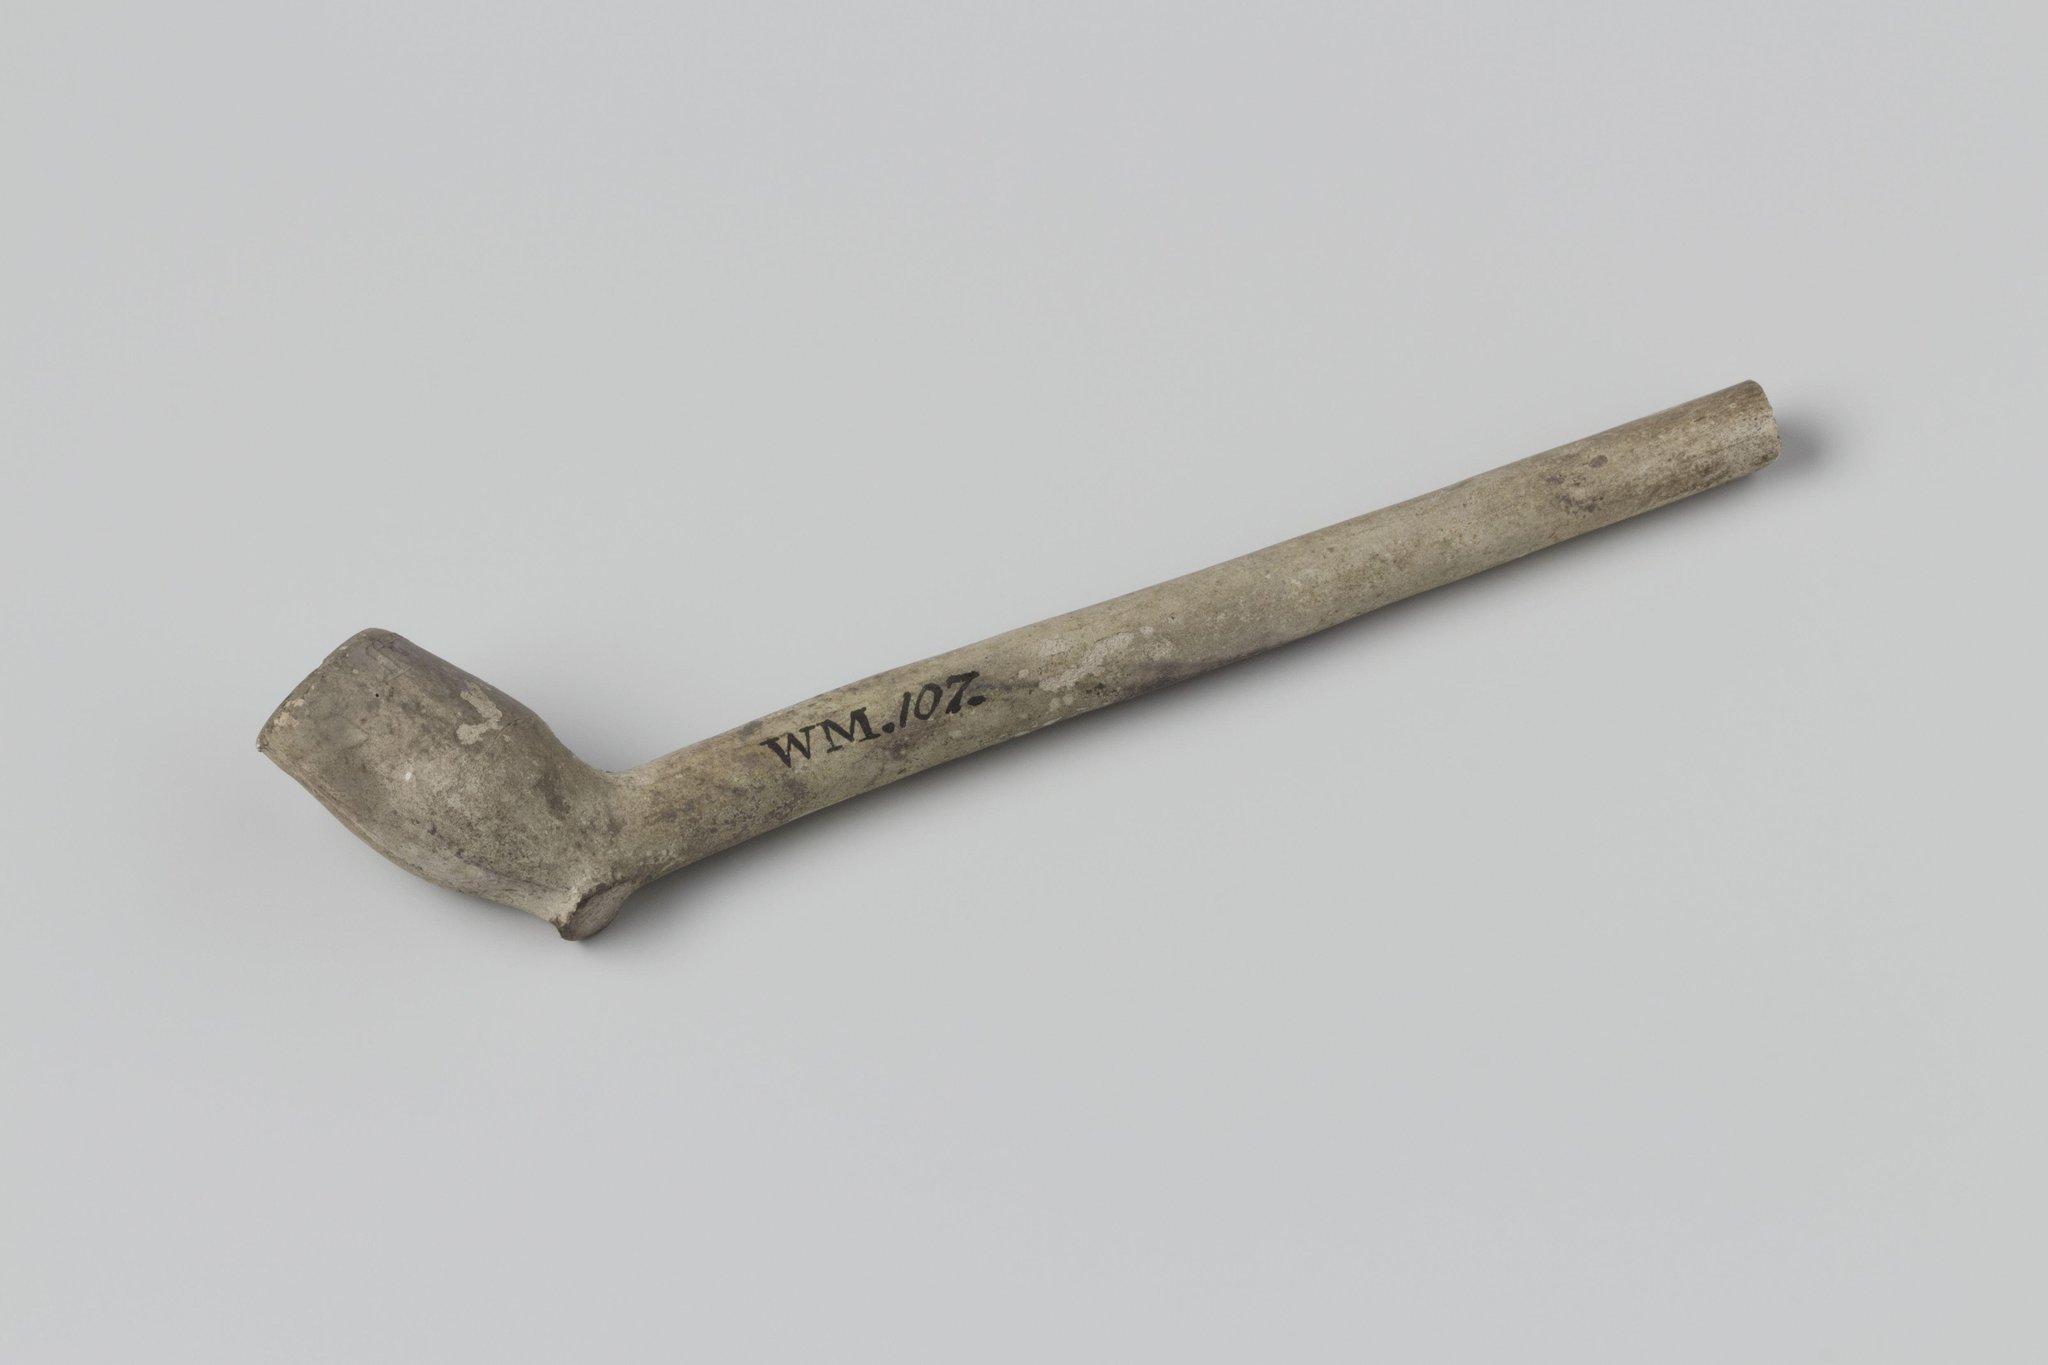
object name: pipe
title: Pijp van gebakken pijpaarde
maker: Anonymous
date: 1400-1950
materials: earthenware, clay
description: Pijp van gebakken pijpaarde met gladde steel. Een stuk uit de steel ontbreekt, de kop is beschadigd.